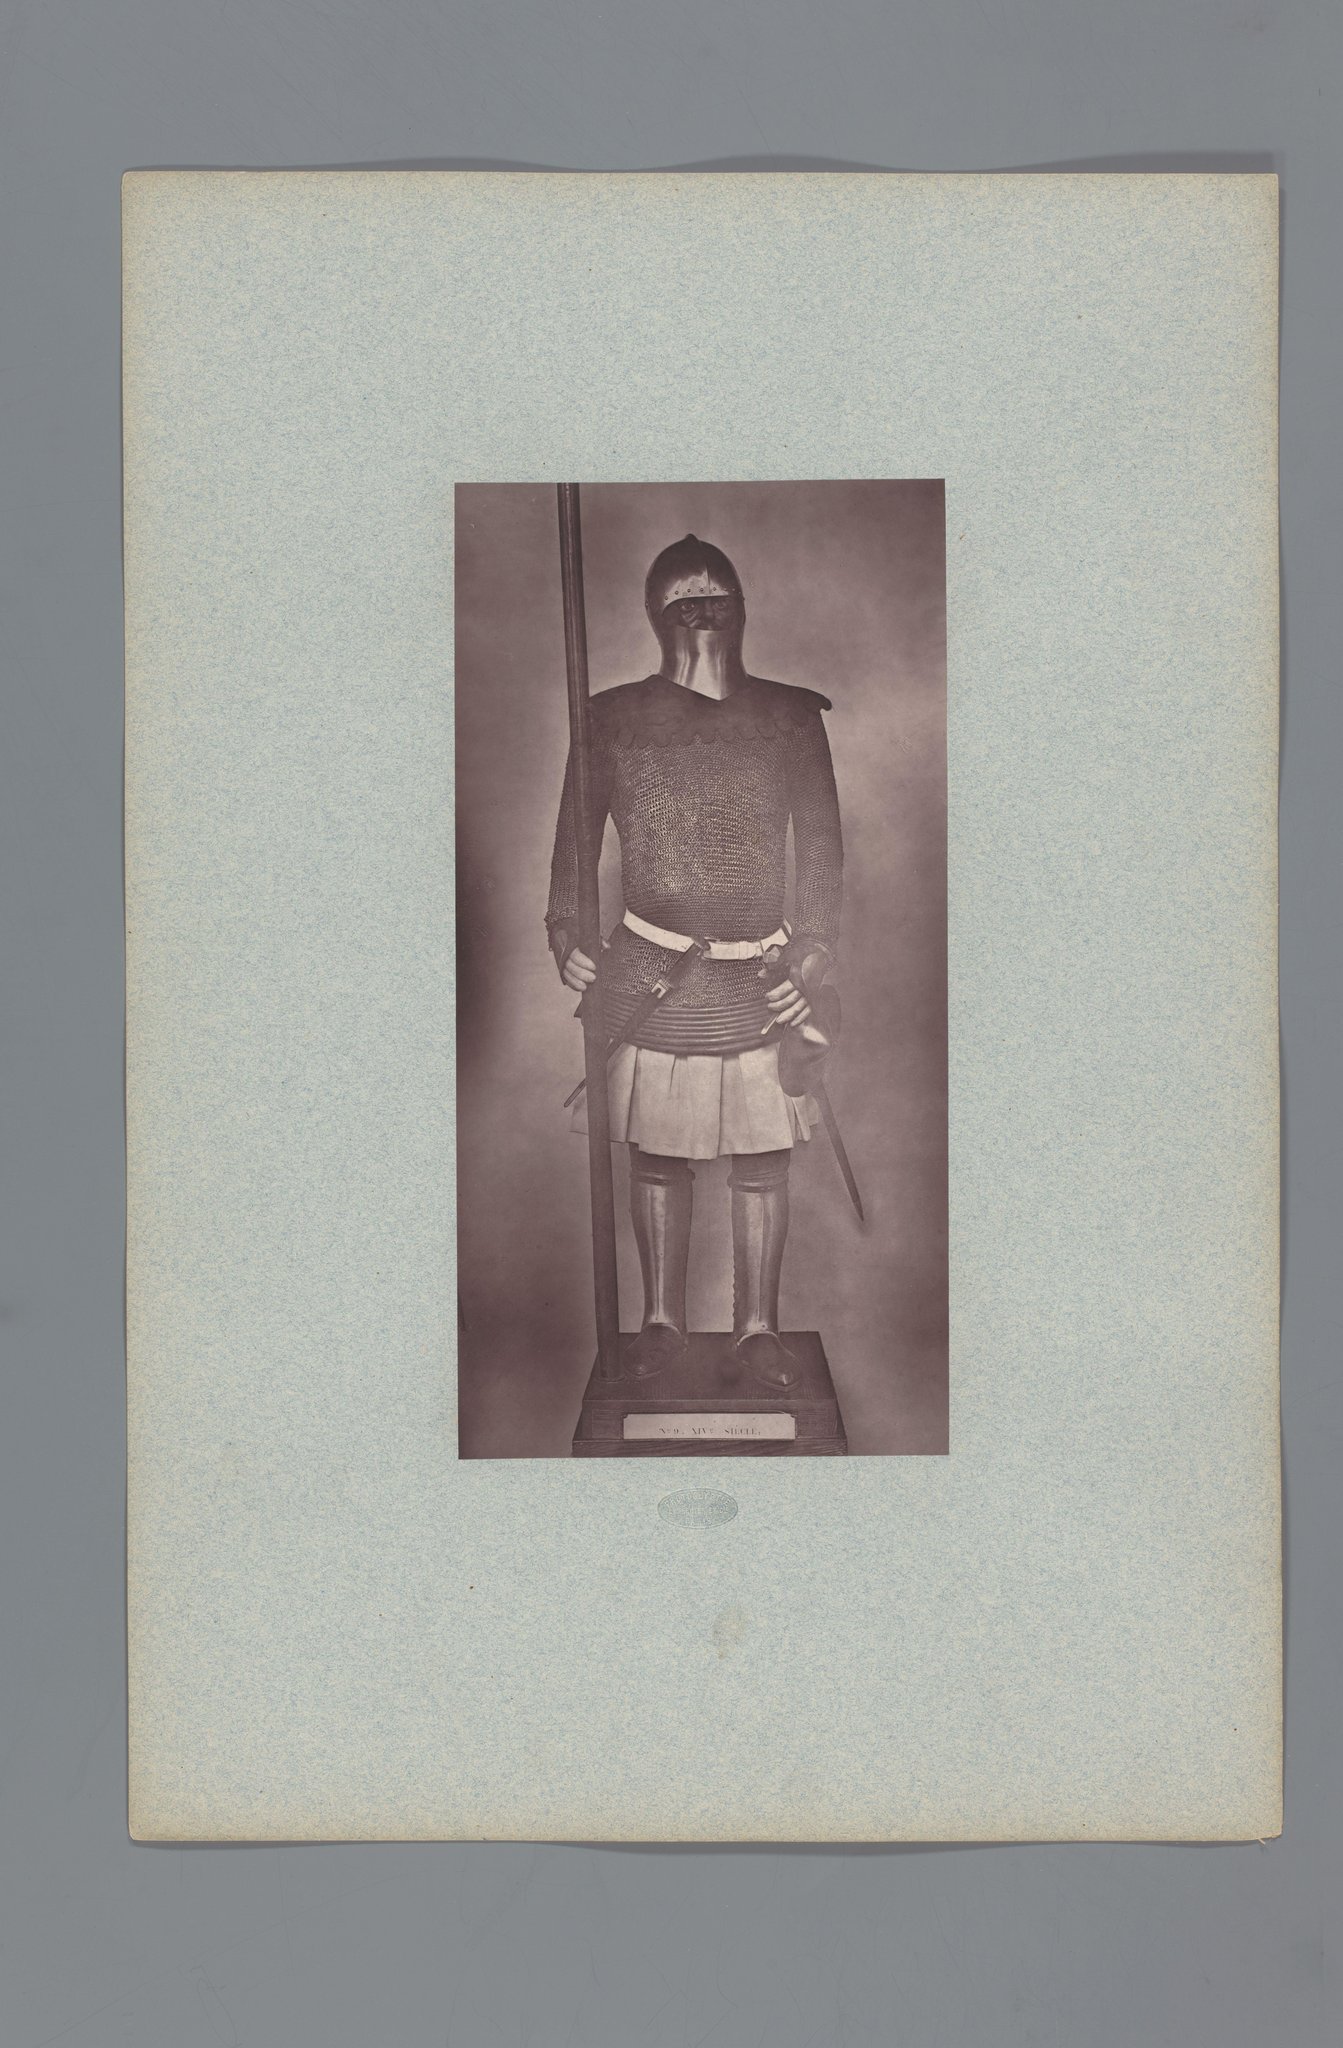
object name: photomechanical print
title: 14de-eeuws harnas met lans uit het leger van Jan II van Frankrijk, uit de collectie van het Musée d'Artillerie in Parijs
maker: Anonymous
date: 1877-1882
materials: paper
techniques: woodburytype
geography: paris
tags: armour, helved weapons, polearms (for striking, hacking, thrusting): lance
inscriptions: check stamp: ‘PHOTOGLYPTIE/ LEMERCIER ET Cie/ PARIS’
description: Deze prent maakt deel uit van een omslag met 36 prenten, een titelblad en een lijst van afbeeldingen.